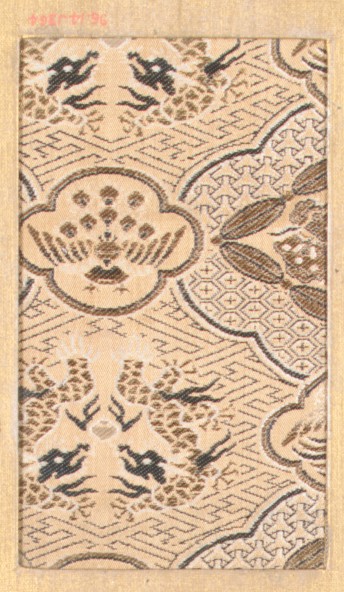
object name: piece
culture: japanese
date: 1701-1900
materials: silk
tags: dragons,peacocks